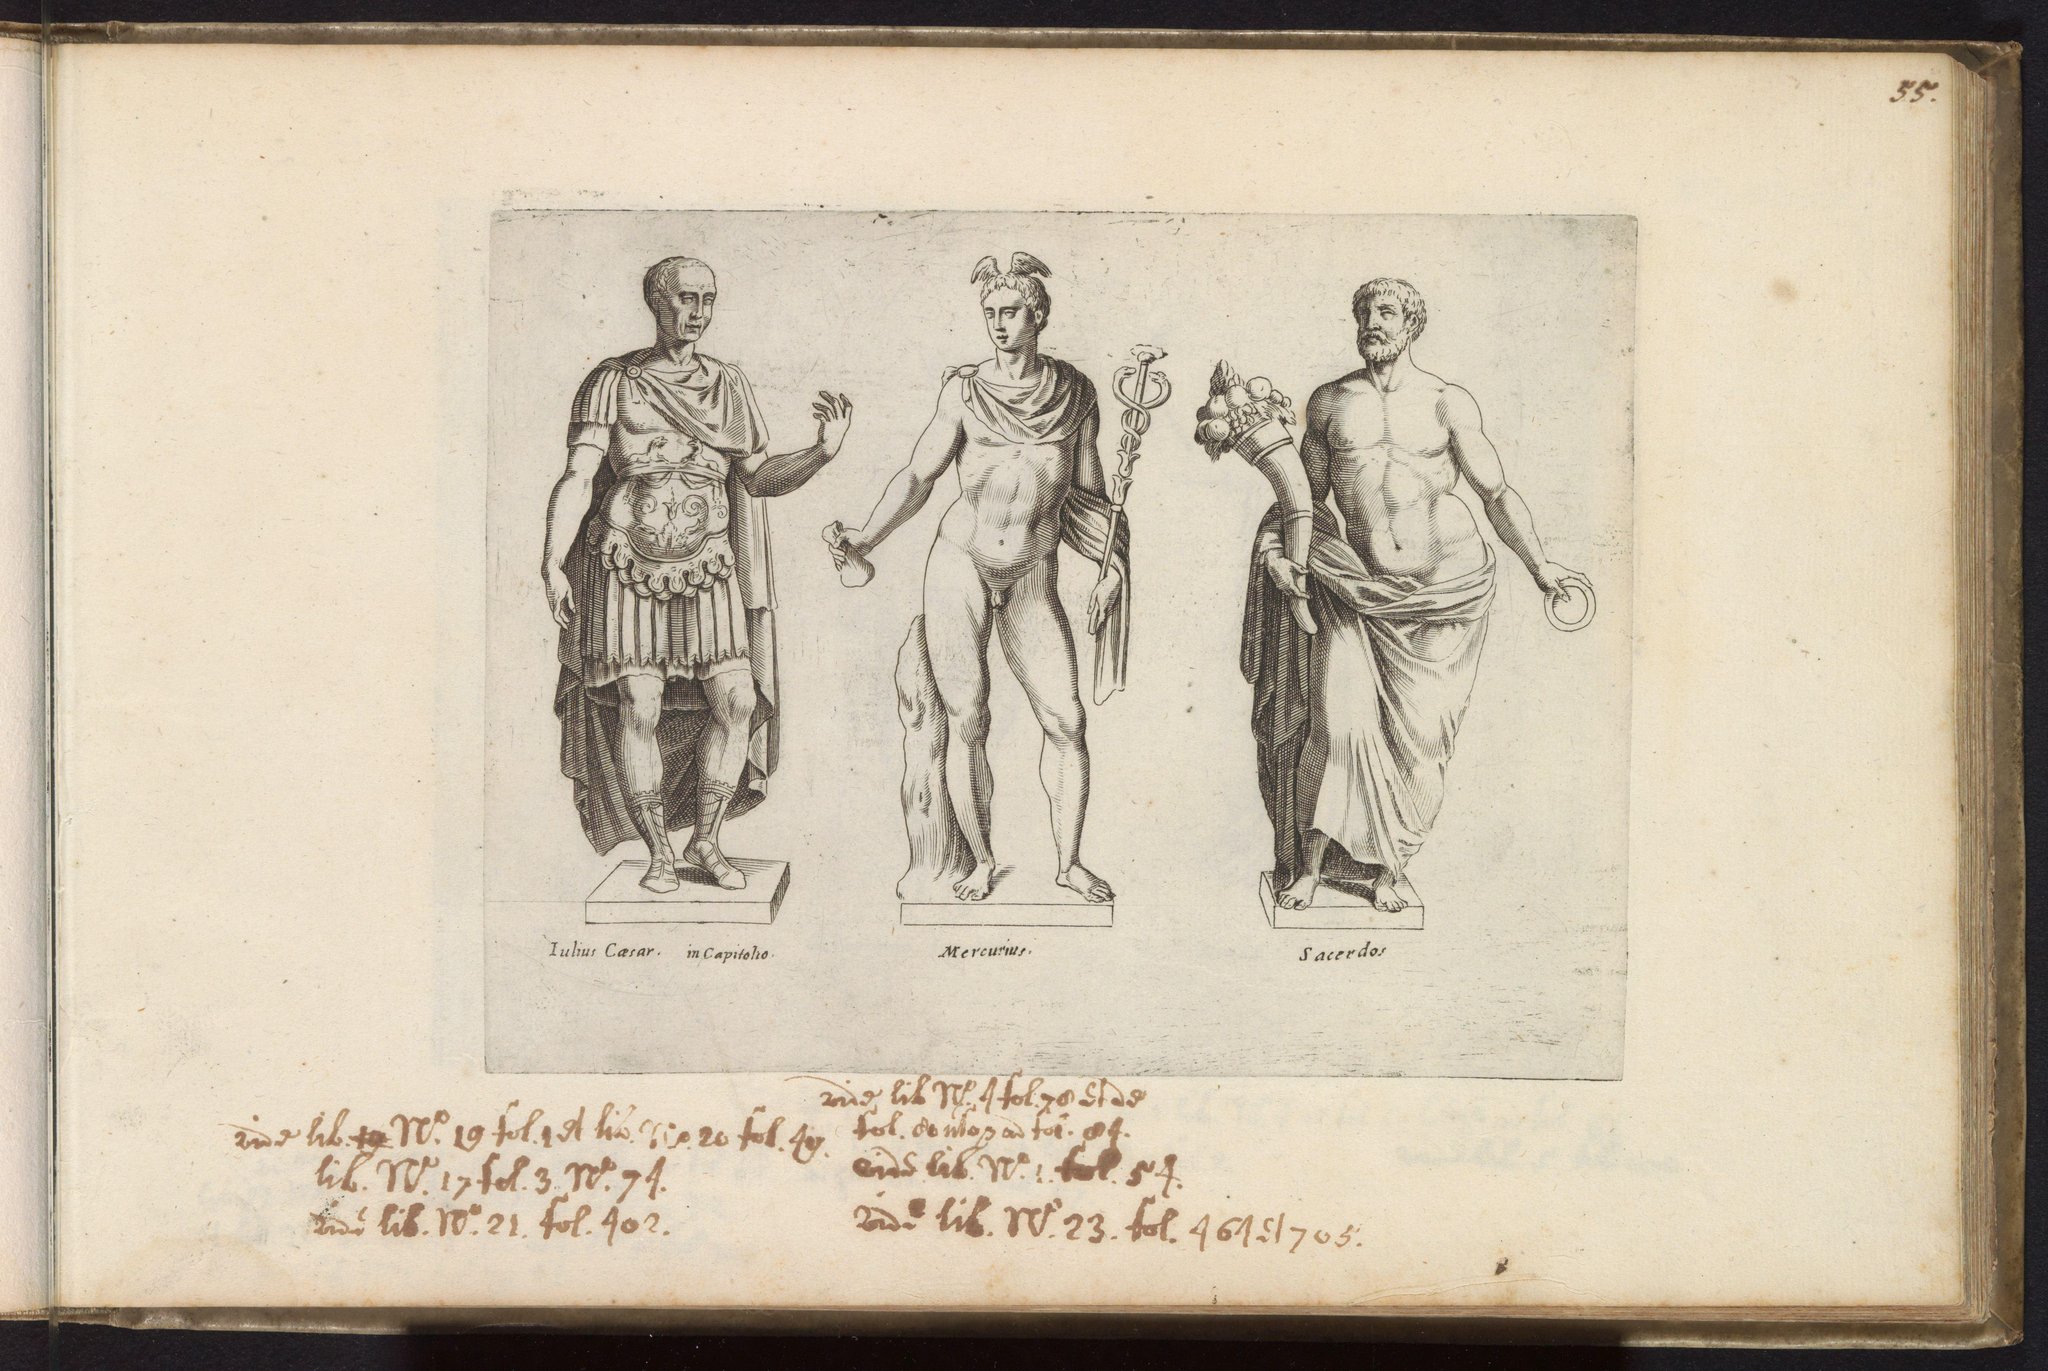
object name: print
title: Sculpturen van Julius Caesar, Mercurius en een priester met een hoorn des overvloeds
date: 1538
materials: paper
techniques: engraving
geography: vatican city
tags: priest ~ roman religion, (story of) mercury (hermes), piece of sculpture, reproduction of a piece of sculpture, (story of) c. julius caesar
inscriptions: number: ‘55’, inscription: ‘Ende lib. No. 19 fol. 1 et lib. No. 20 fol. 49...’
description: Deze prent maakt deel uit van een reeks van ten minste 19 prenten van sculpturen uit de oudheid. Het beeld van Caesar bevindt zich in de Capitolijnse Musea te Rome.